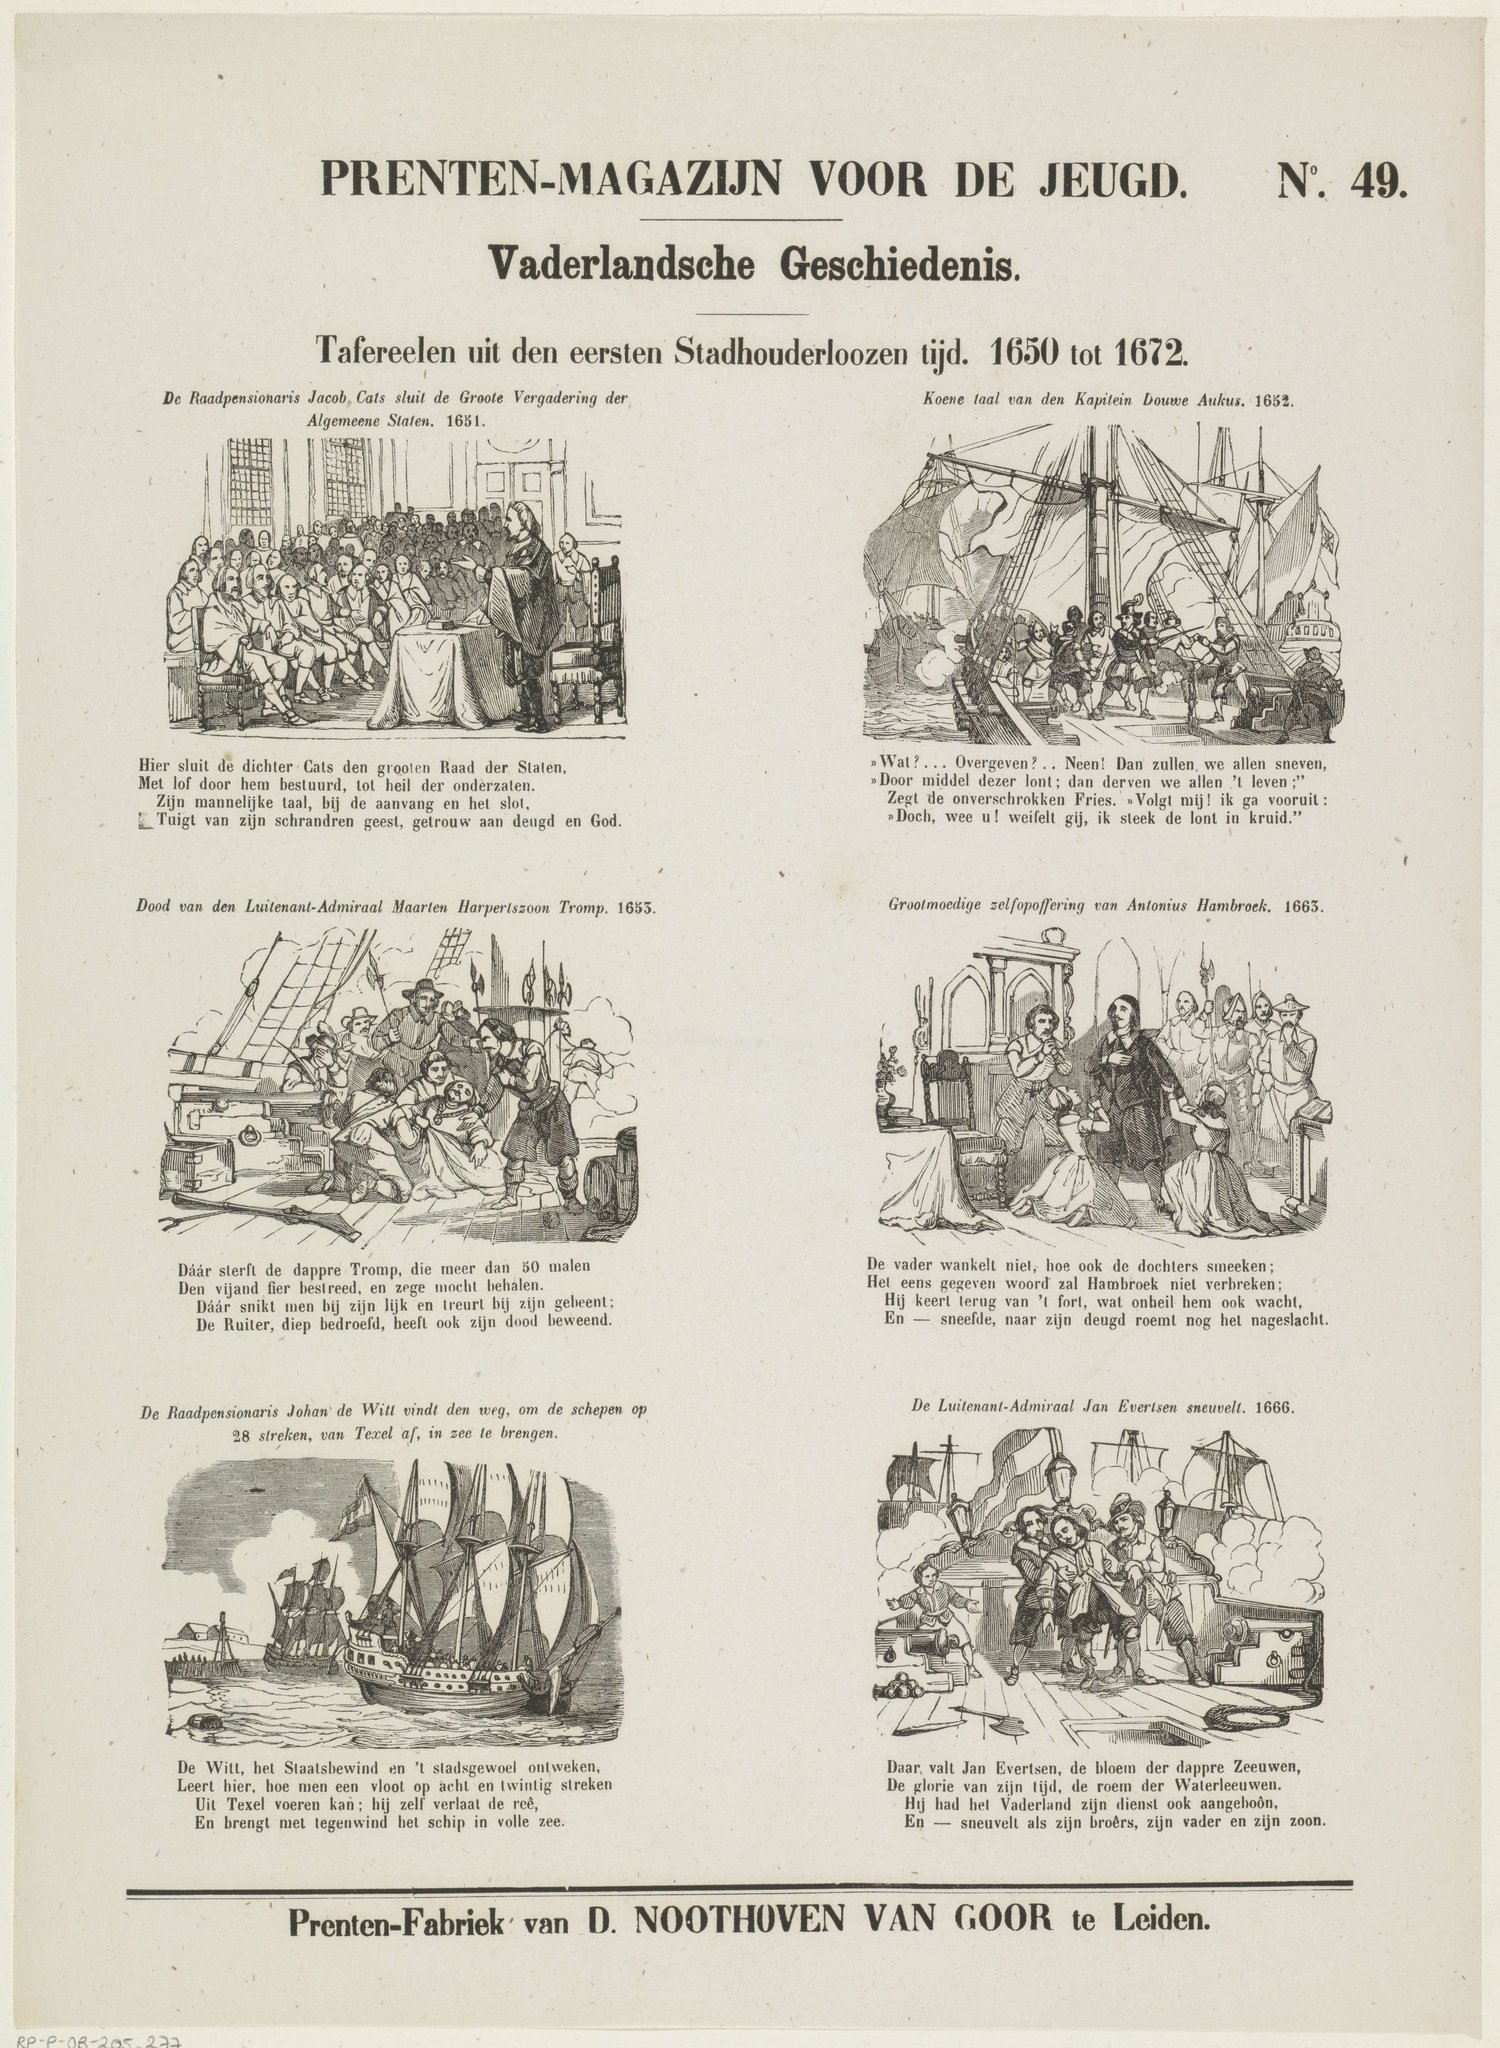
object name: print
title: Vaderlandsche geschiedenis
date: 1850-1881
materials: paper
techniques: letterpress printing, engraving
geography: netherlands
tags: formosa, the hague, politician, johan de witt, jacob cats (1577-1660), brielle, maarten harpertszoon tromp, history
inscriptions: collector's mark: Lugt 2760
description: Blad met 6 voorstellingen van gebeurtenissen ten tijde van het Eerste Stadhouderloze Tijdperk tussen 1650 en 1672. Boven elke voorstelling een titel en onder elke voorstelling een vierregelig vers. Genummerd rechtsboven: No. 49.